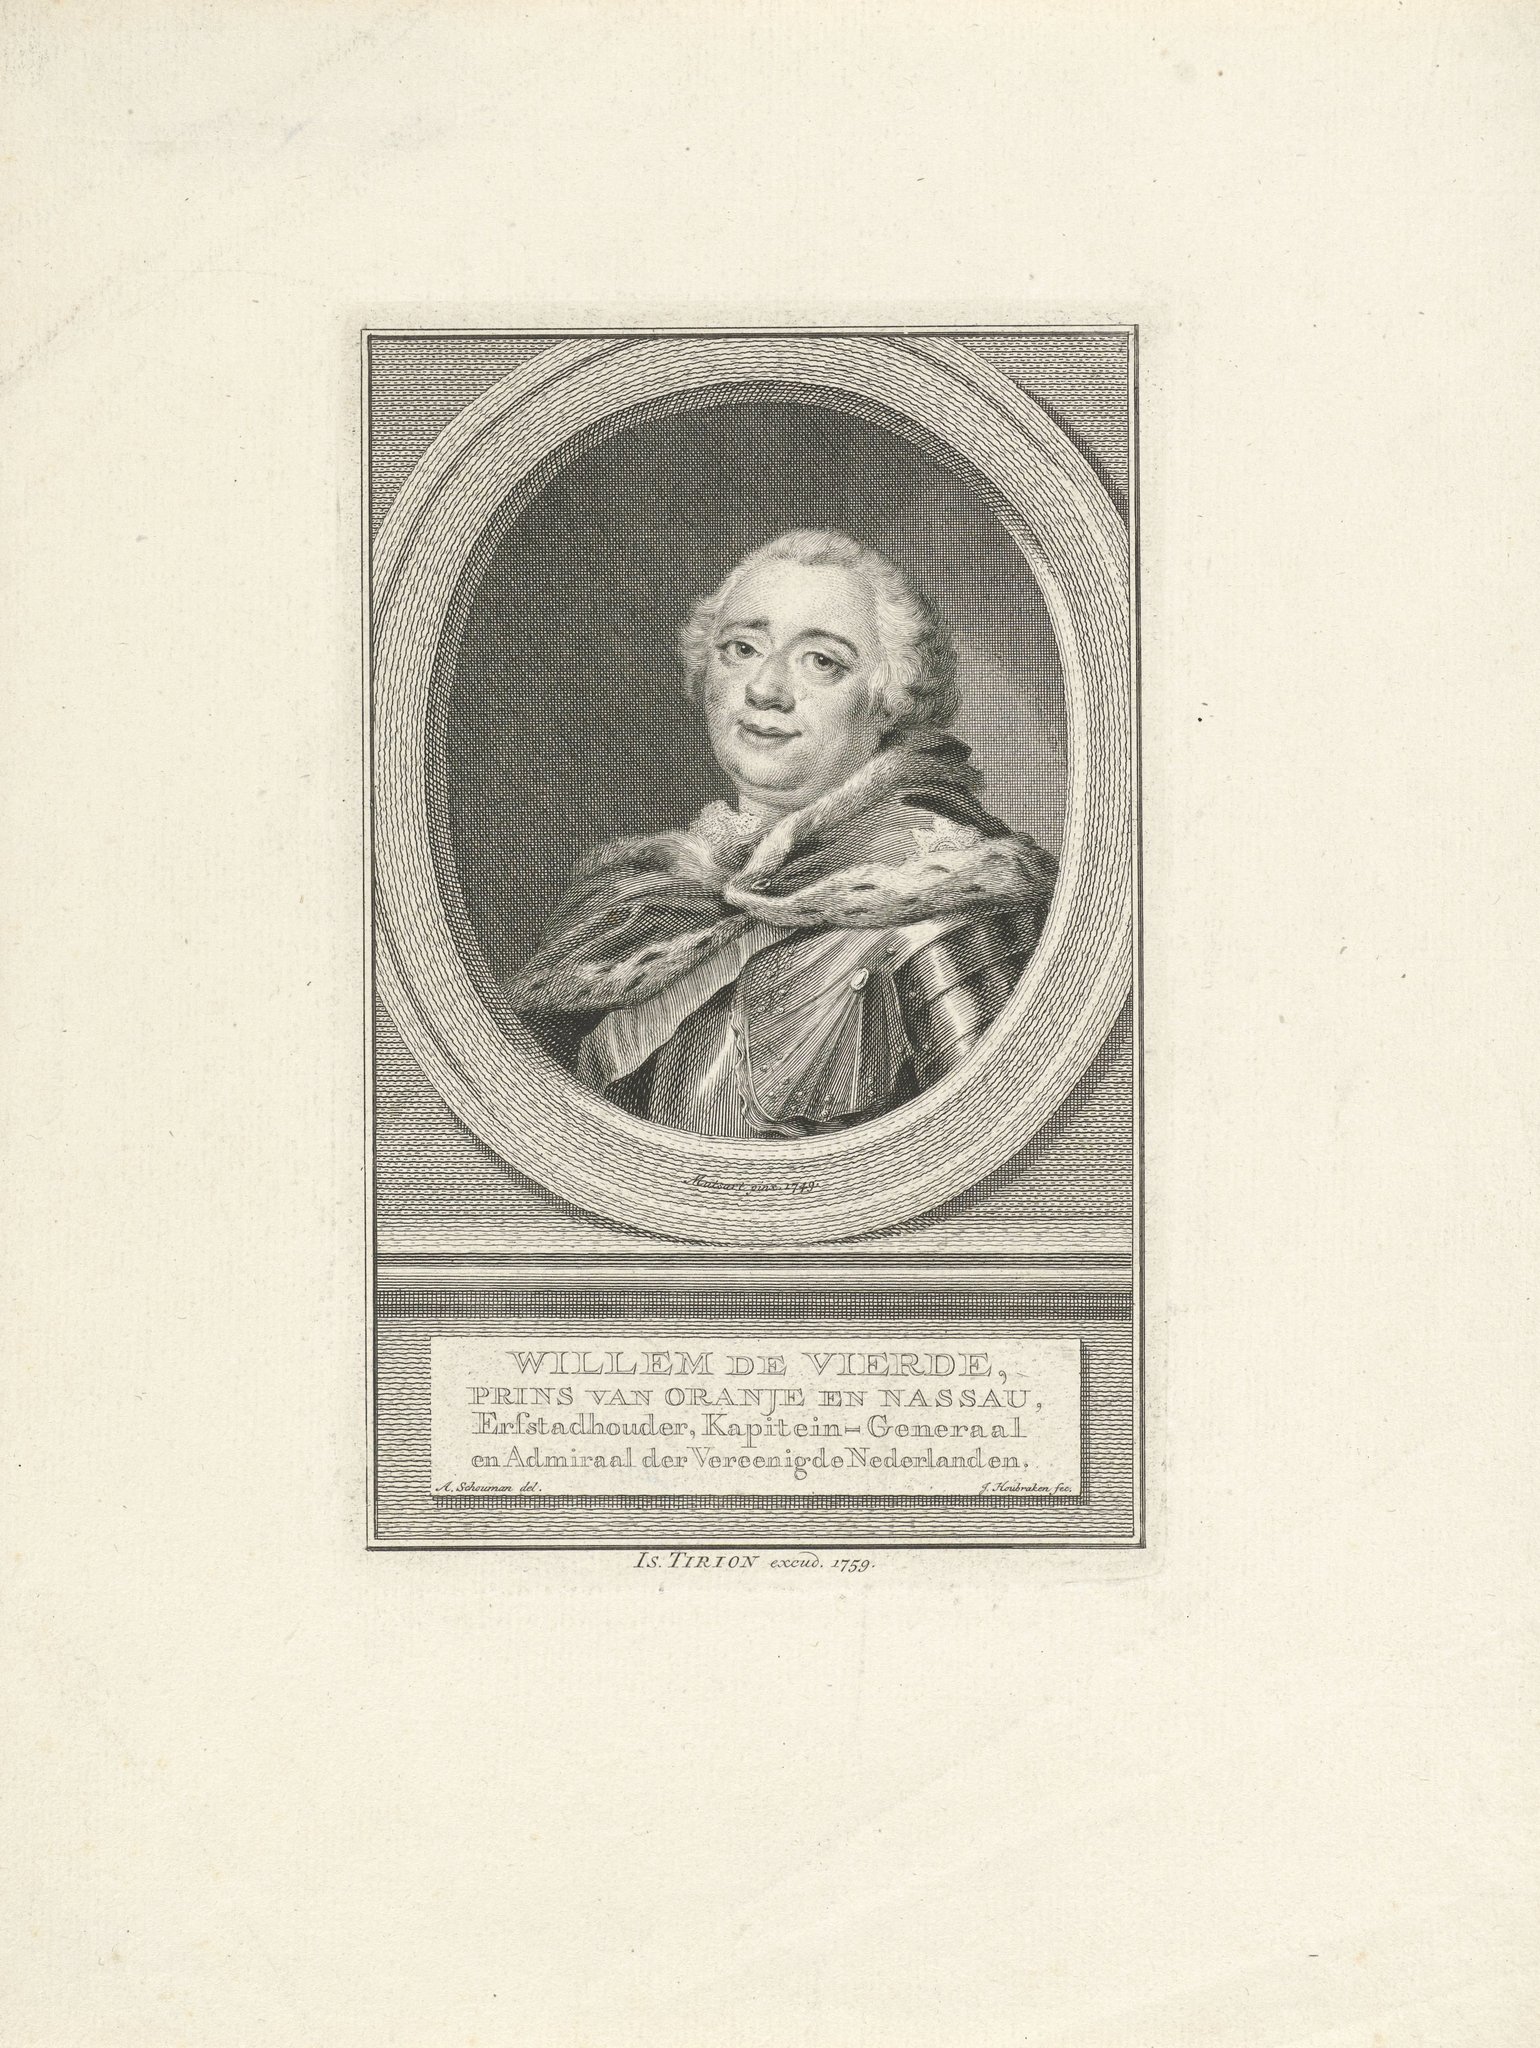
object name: print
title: Portret van Willem IV, prins van Oranje-Nassau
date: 1759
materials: paper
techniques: engraving, etching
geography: amsterdam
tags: willem iv (prins van oranje-nassau)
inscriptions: collector's mark: Lugt 2228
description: Prent ook gebruikt in: Jan Wagenaar, Vaderlandsche historie, vervattende de geschiedenissen der nu Vereenigde Nederlanden, inzonderheid die van Holland (...), 21 delen. Amsterdam, Isaak Tirion, 1749-59.